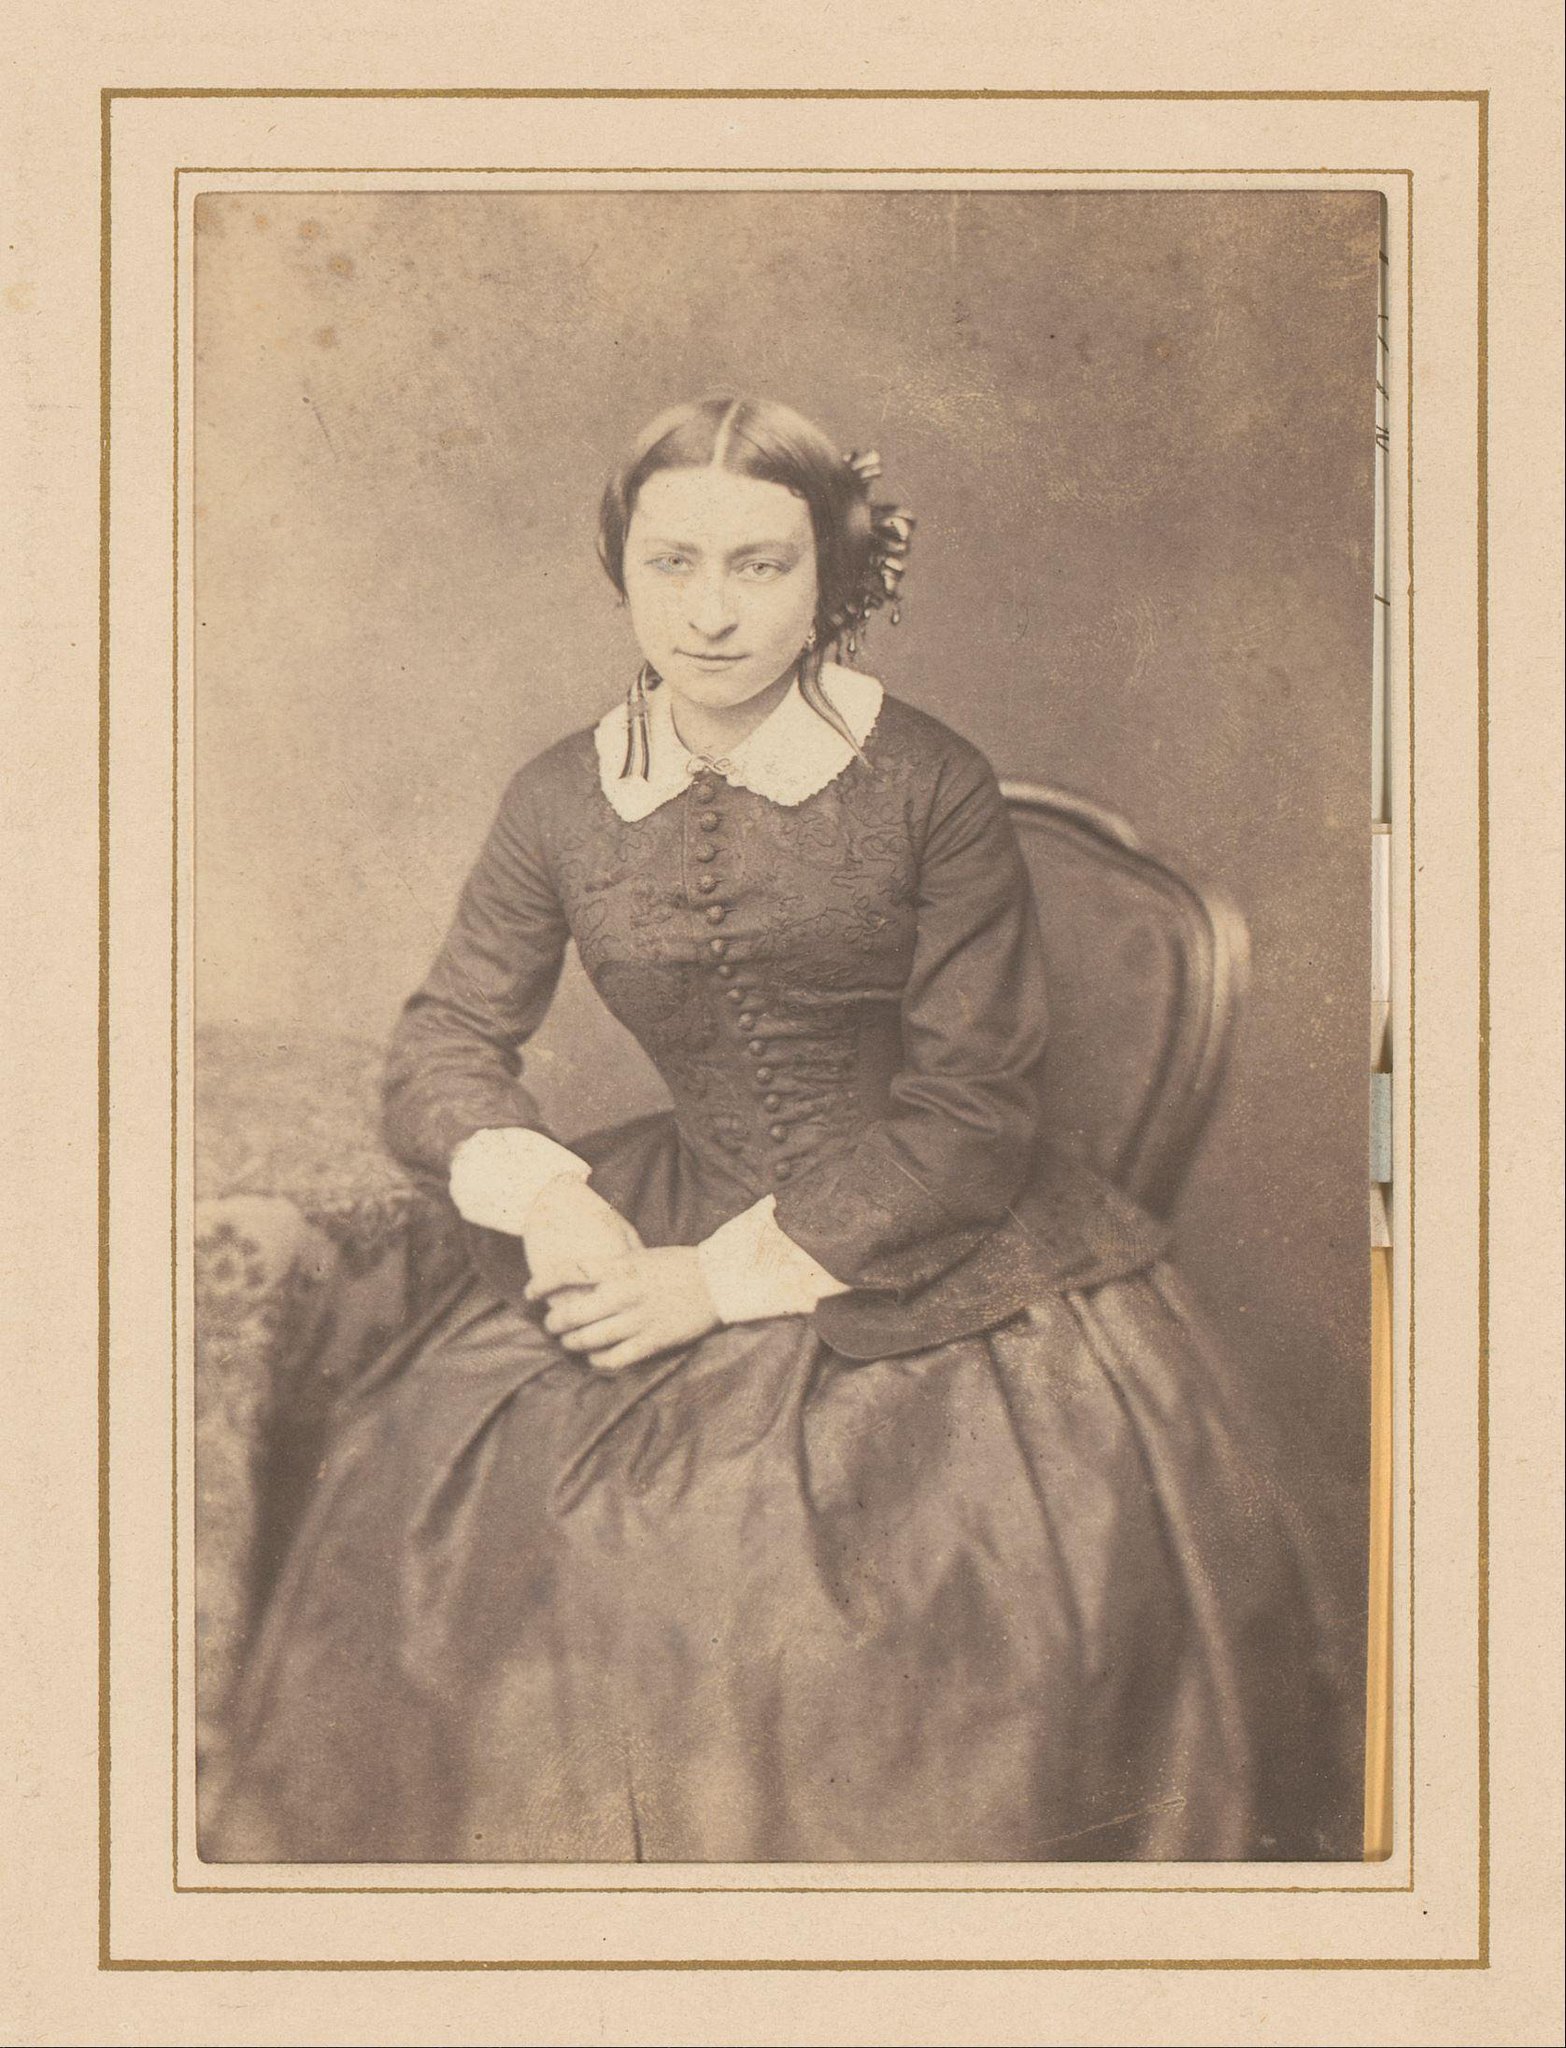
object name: album leaf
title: Portret van een vrouw, zittend aan een tafel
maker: Anonymous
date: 1839-1855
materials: cardboard, photographic support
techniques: salted paper print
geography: belgium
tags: sitting figure - aa - female human figure, historical persons - bb - woman, table